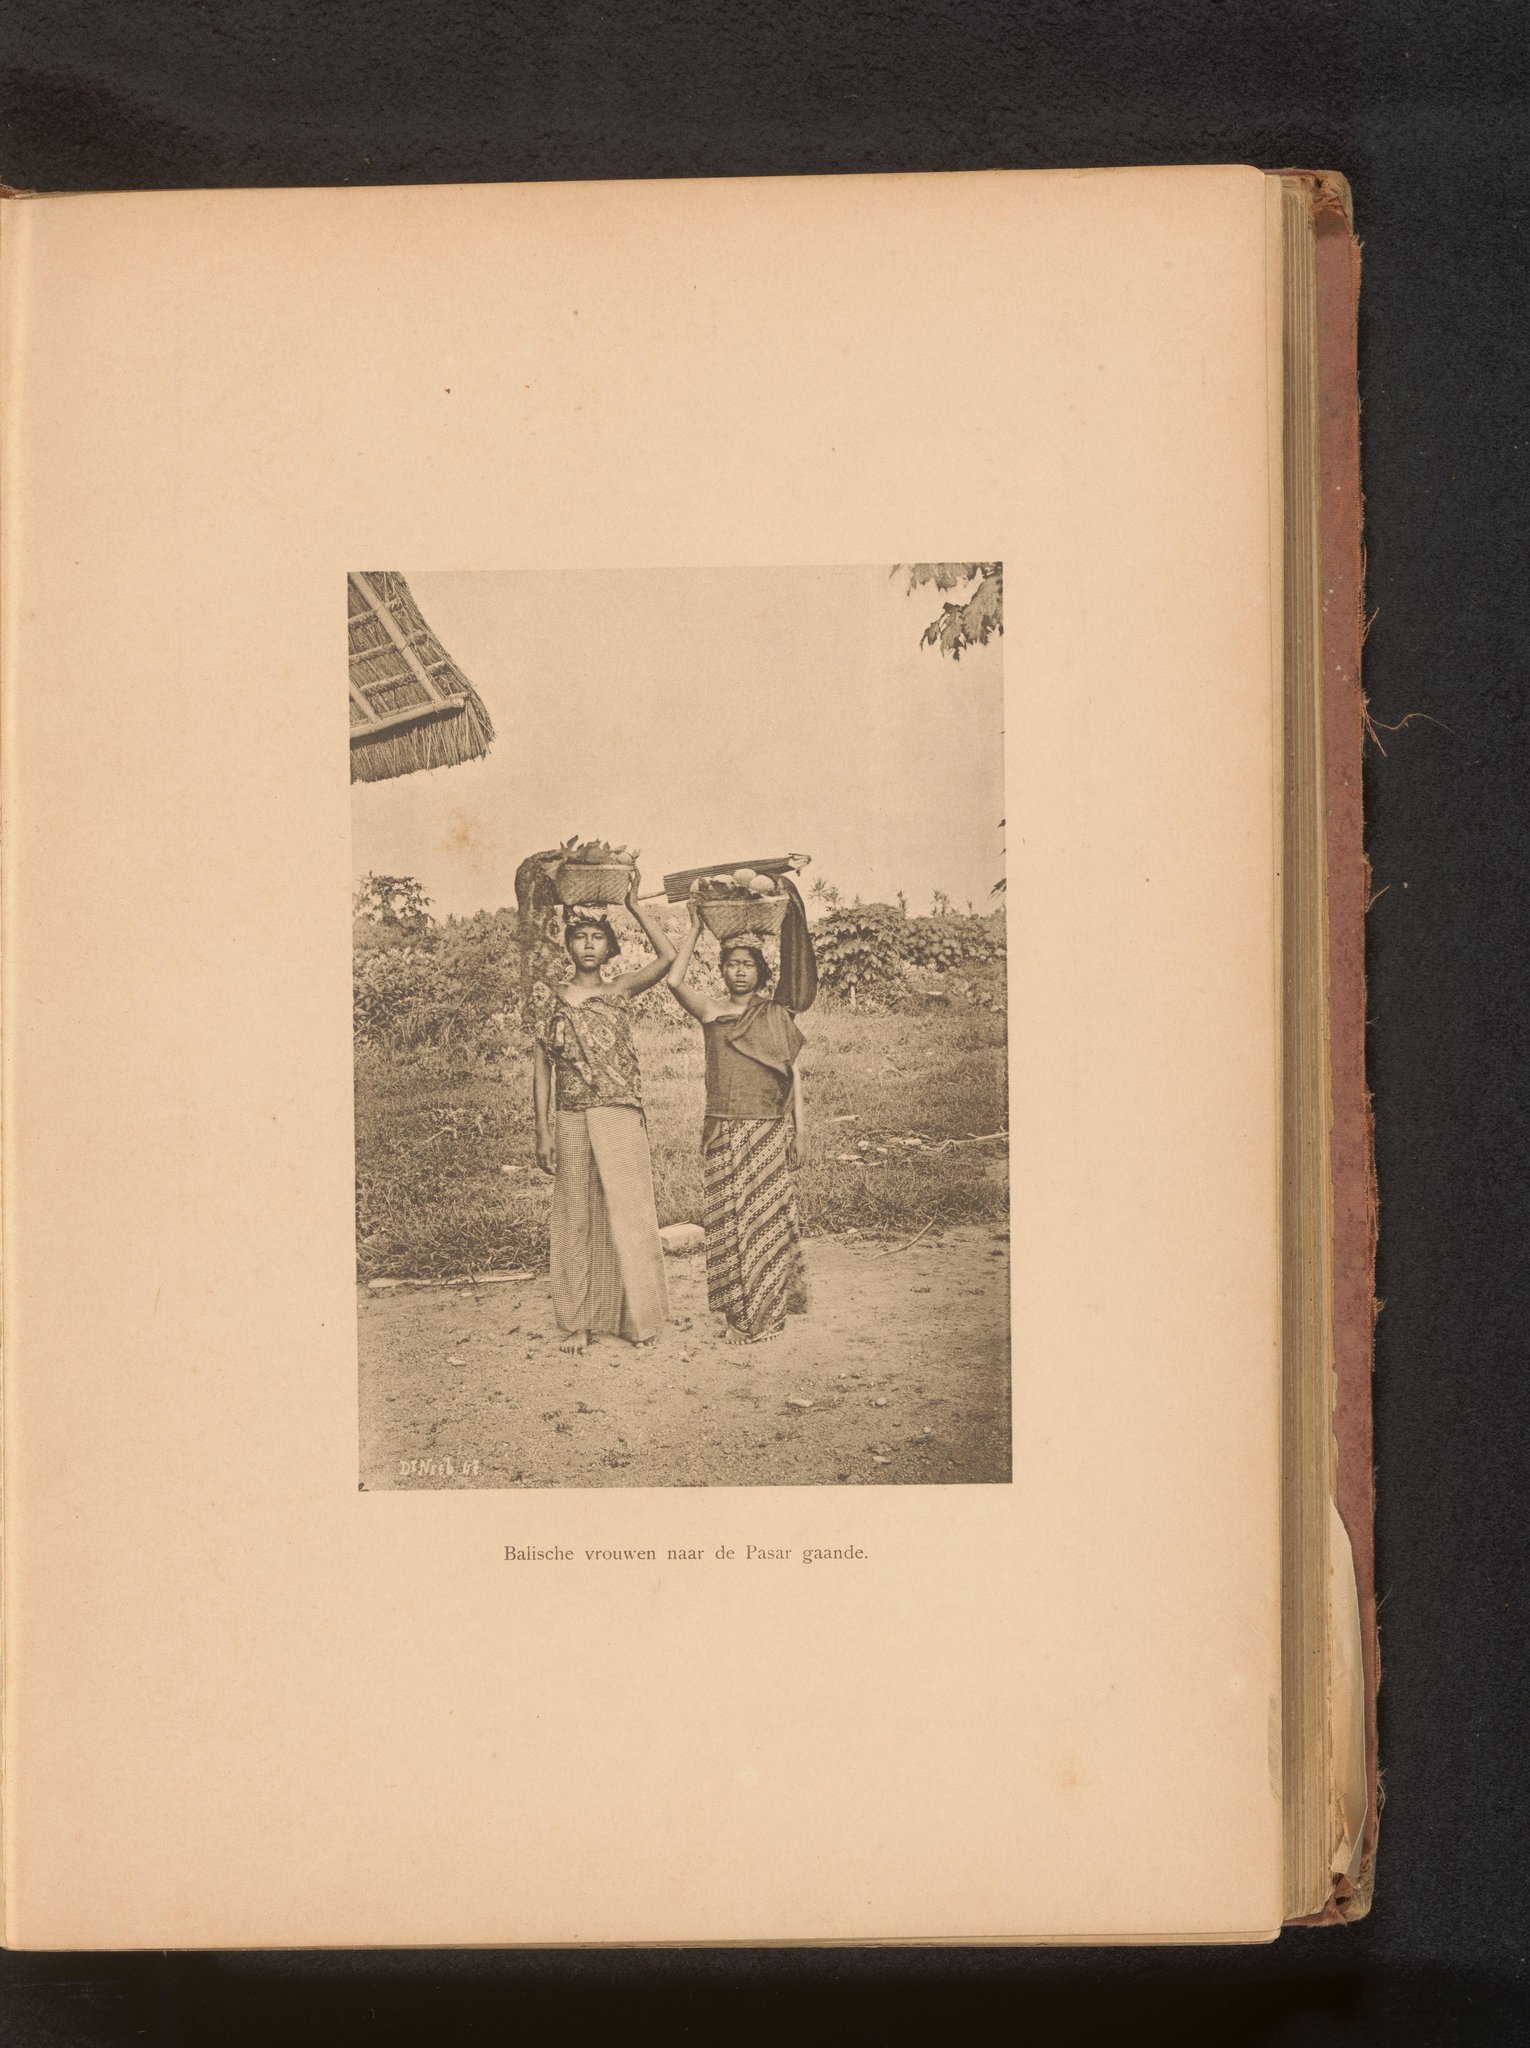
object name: page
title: Twee onbekende vrouwen die een mand op het hoofd dragen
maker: christiaan johan neeb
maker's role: arts, fotograaf, officier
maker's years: 1860-1925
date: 1892-1897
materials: paper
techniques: photograph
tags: adult woman, historical persons, carrying something on the head or on the shoulders